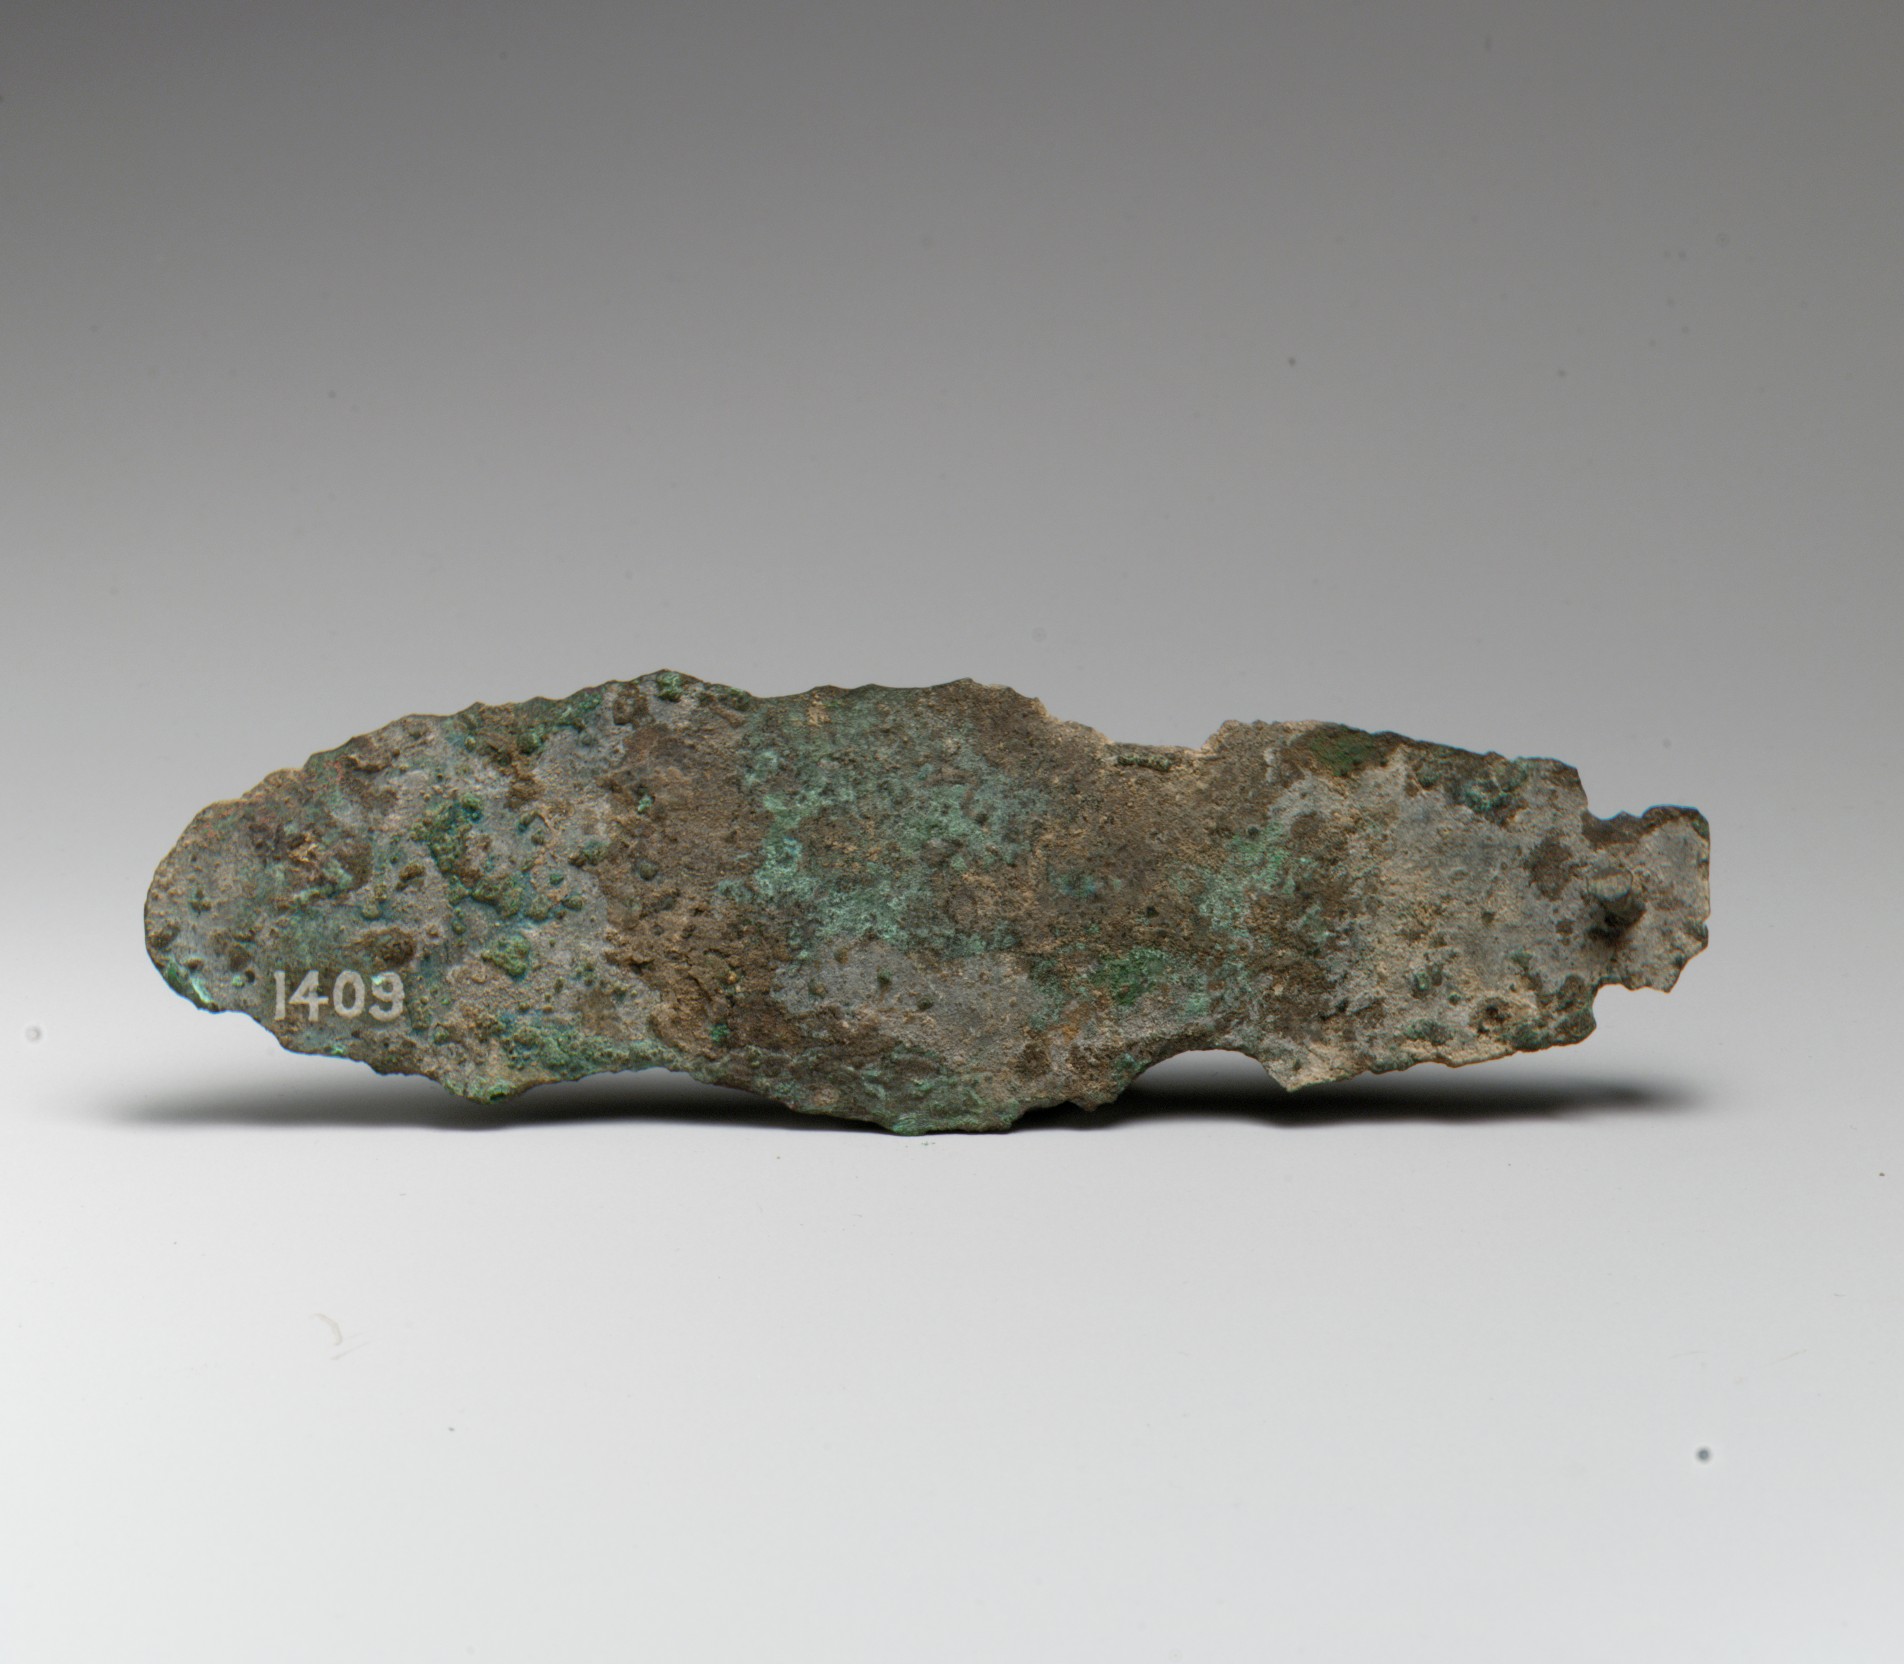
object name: knife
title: Bronze knife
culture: minoan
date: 1600-1050 BCE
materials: bronze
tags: knives